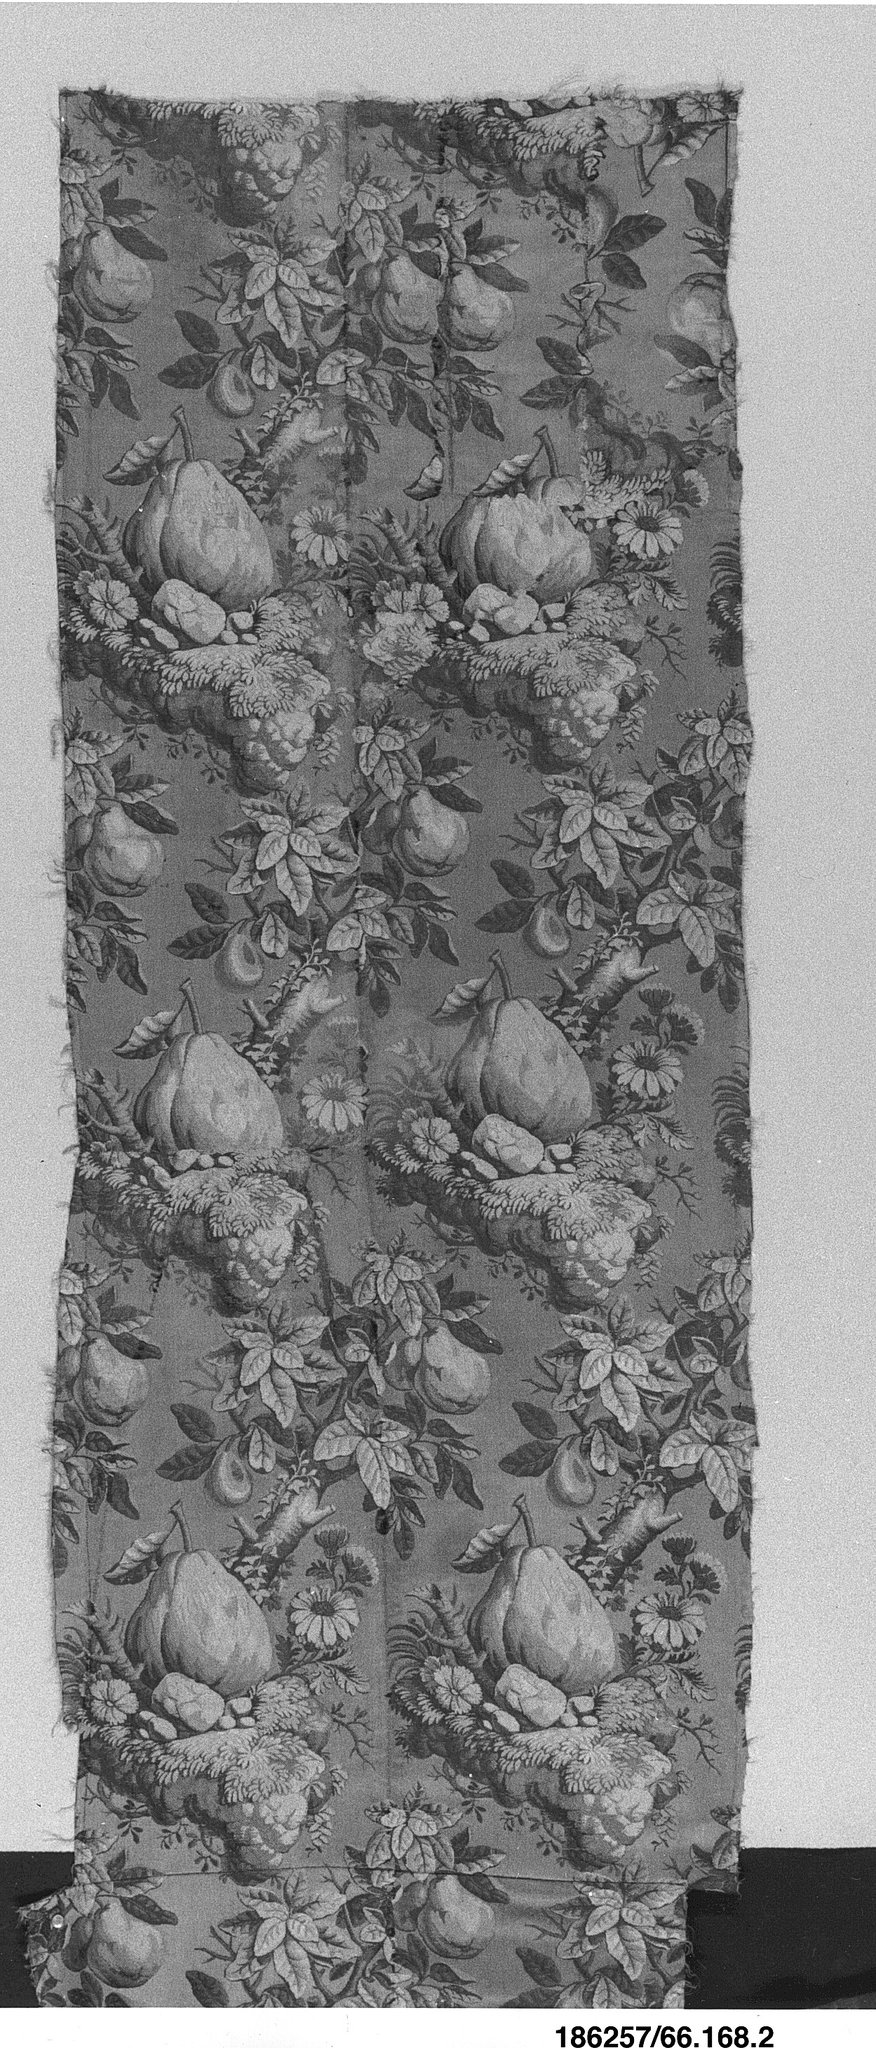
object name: piece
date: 1735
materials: silk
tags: fruit,flowers,leaves